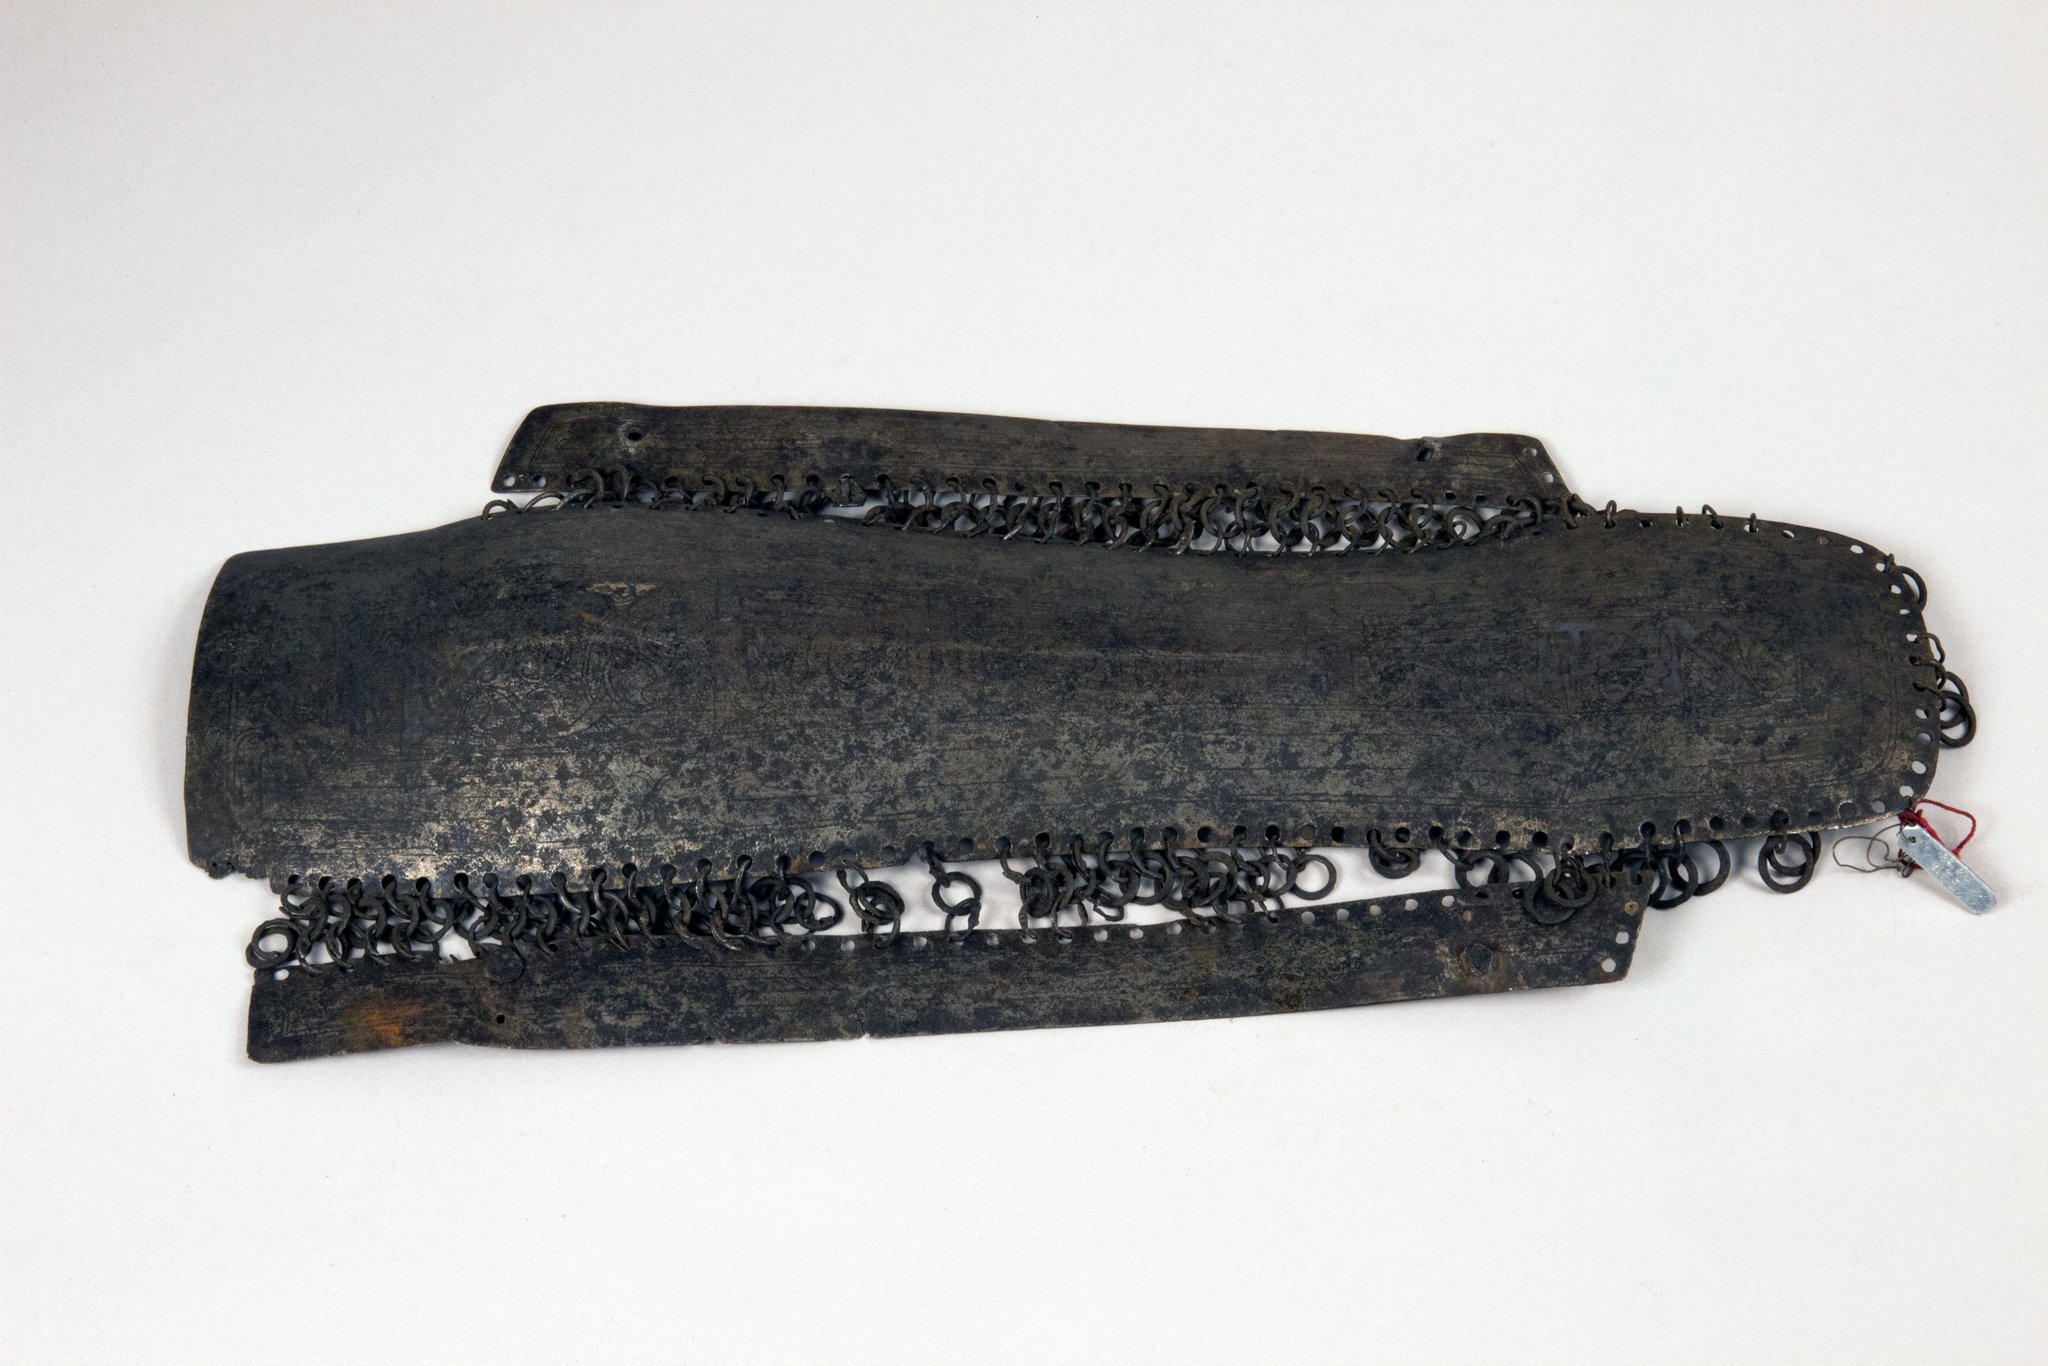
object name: leg guard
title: Right Leg Guard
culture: turkish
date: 1501-1600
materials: silver, steel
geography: ottoman empire